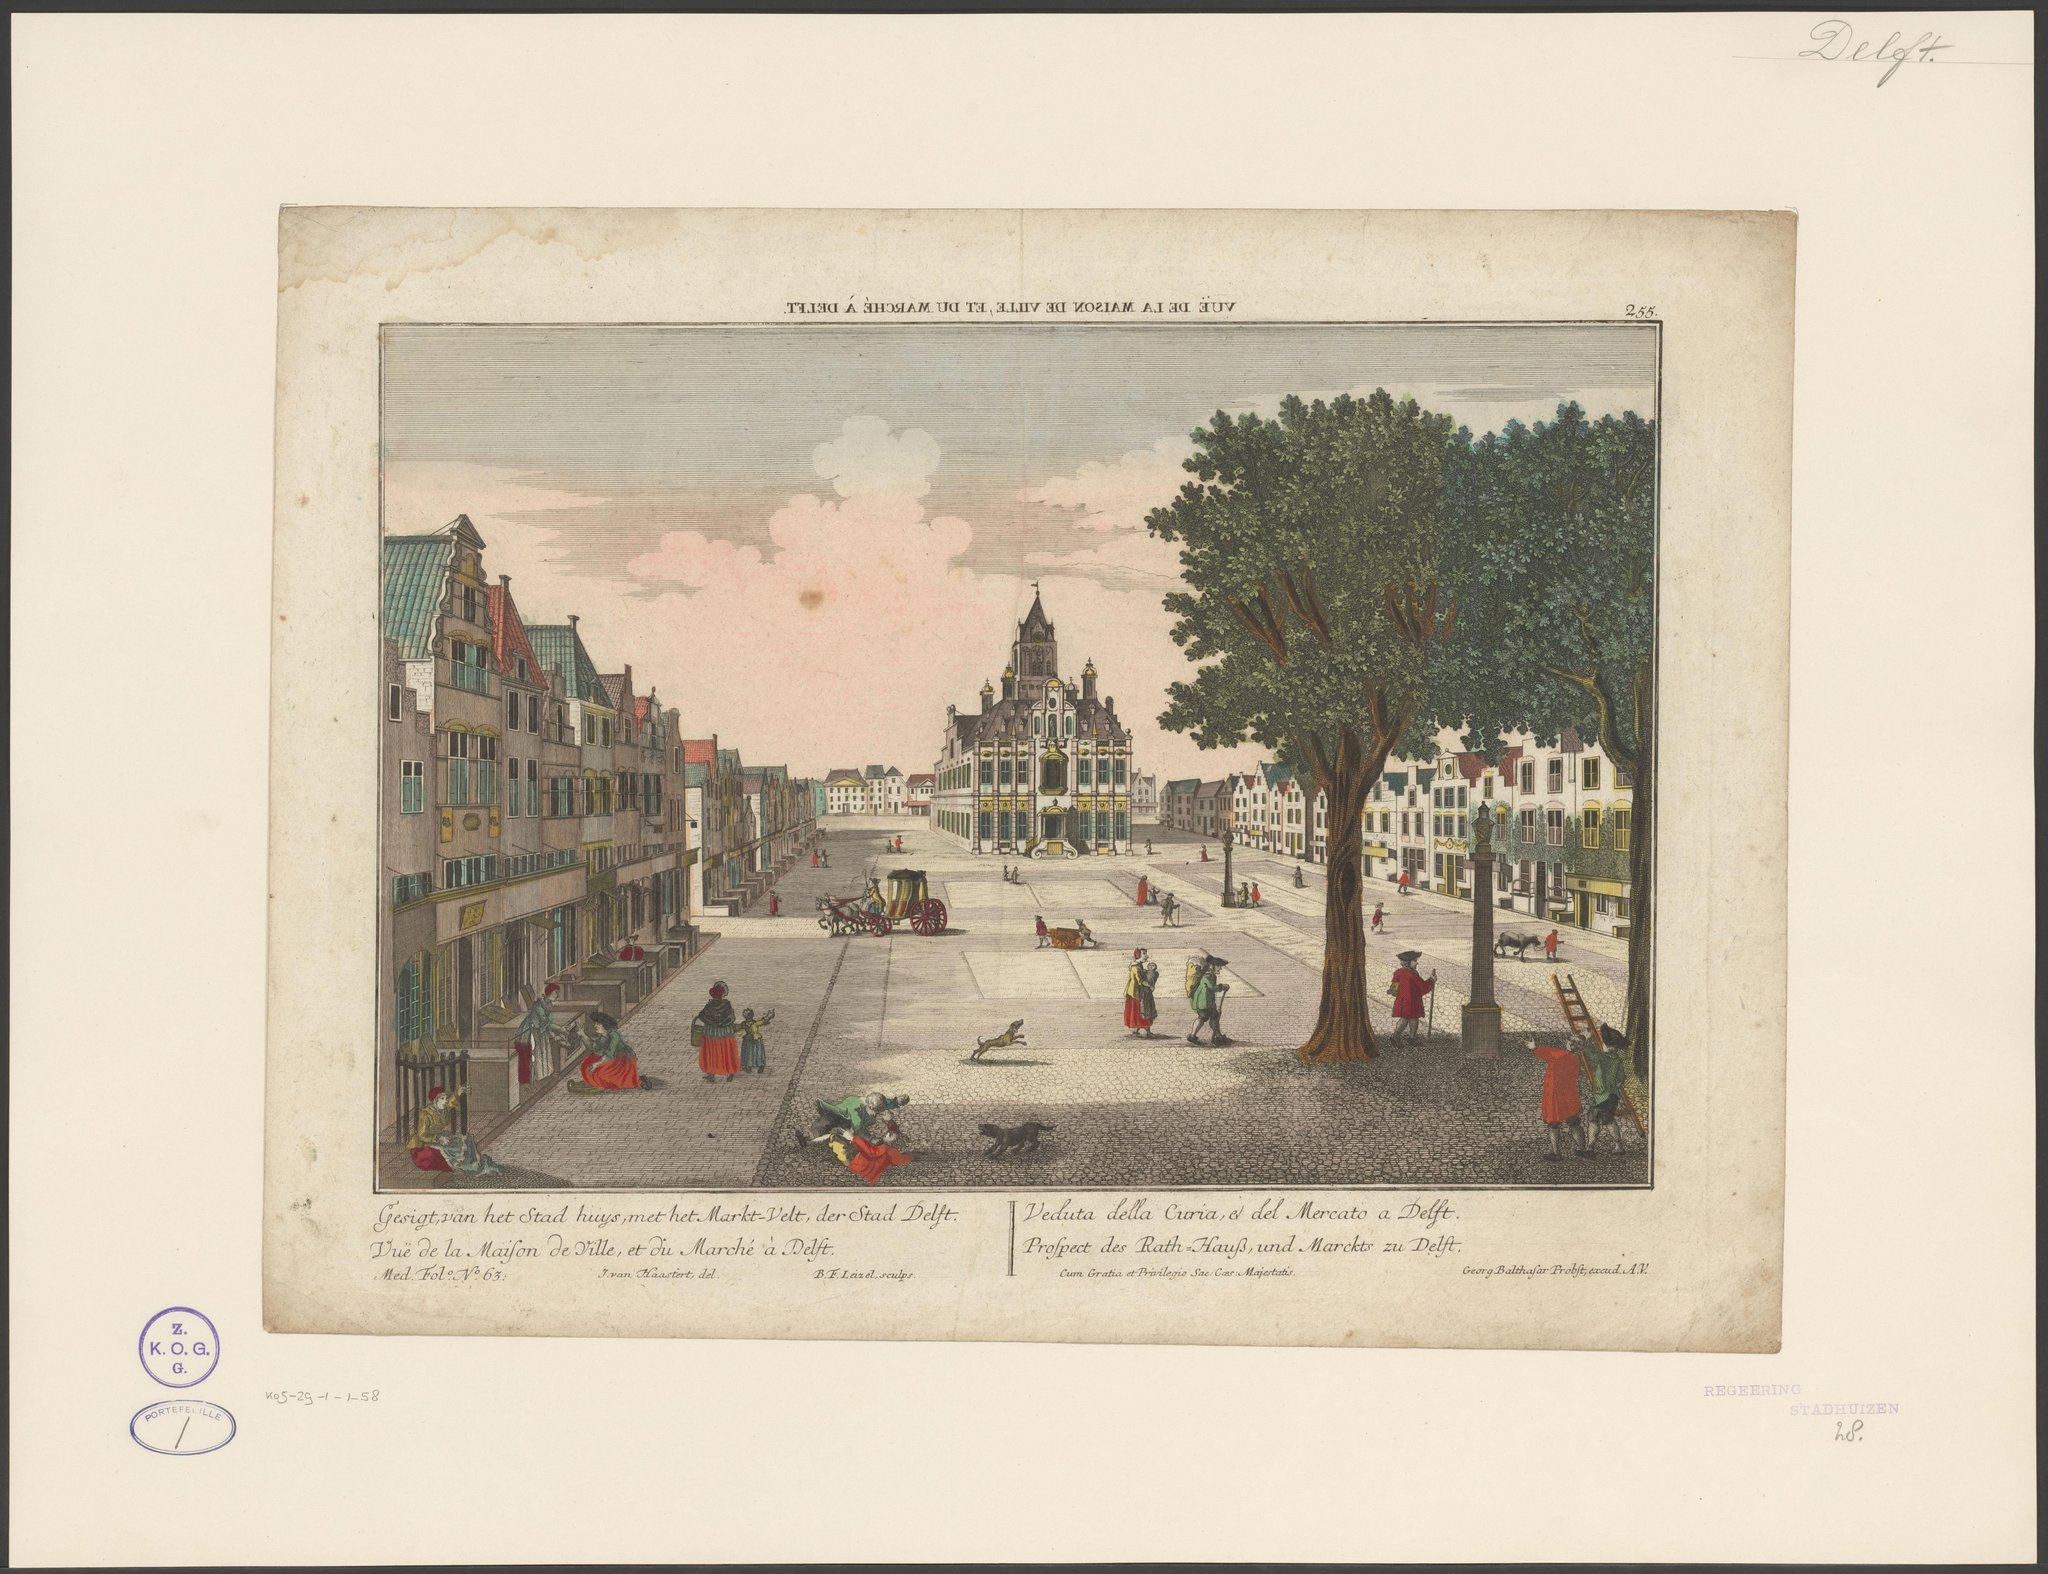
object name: print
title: Gesigt, van den Stad huys, met het Markt-Velt, der Stad Delft / Vuë de la Maison de Ville, et du Marché à Delft / Veduta della Curia, et del Mercato a Delft / Prospect des Rath-Haus, und Marckts zu Delft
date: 1750-1801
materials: paper, watercolor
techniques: etching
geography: germany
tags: square, place, circus, etc., townhall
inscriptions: collector's mark: Lugt 1641, collector's mark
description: Opticaprent met een gezicht op het stadhuis van Delft en Markt. Bovenaan de Franse titel in spiegelschrift. Rechtsboven genummerd: 255. Linksonder: Med. Fol.o No 63. Onderwerpsrubrieken binnen de Atlas Zeden en Gewoonten: Regeering, Stadhuizen (B-D).